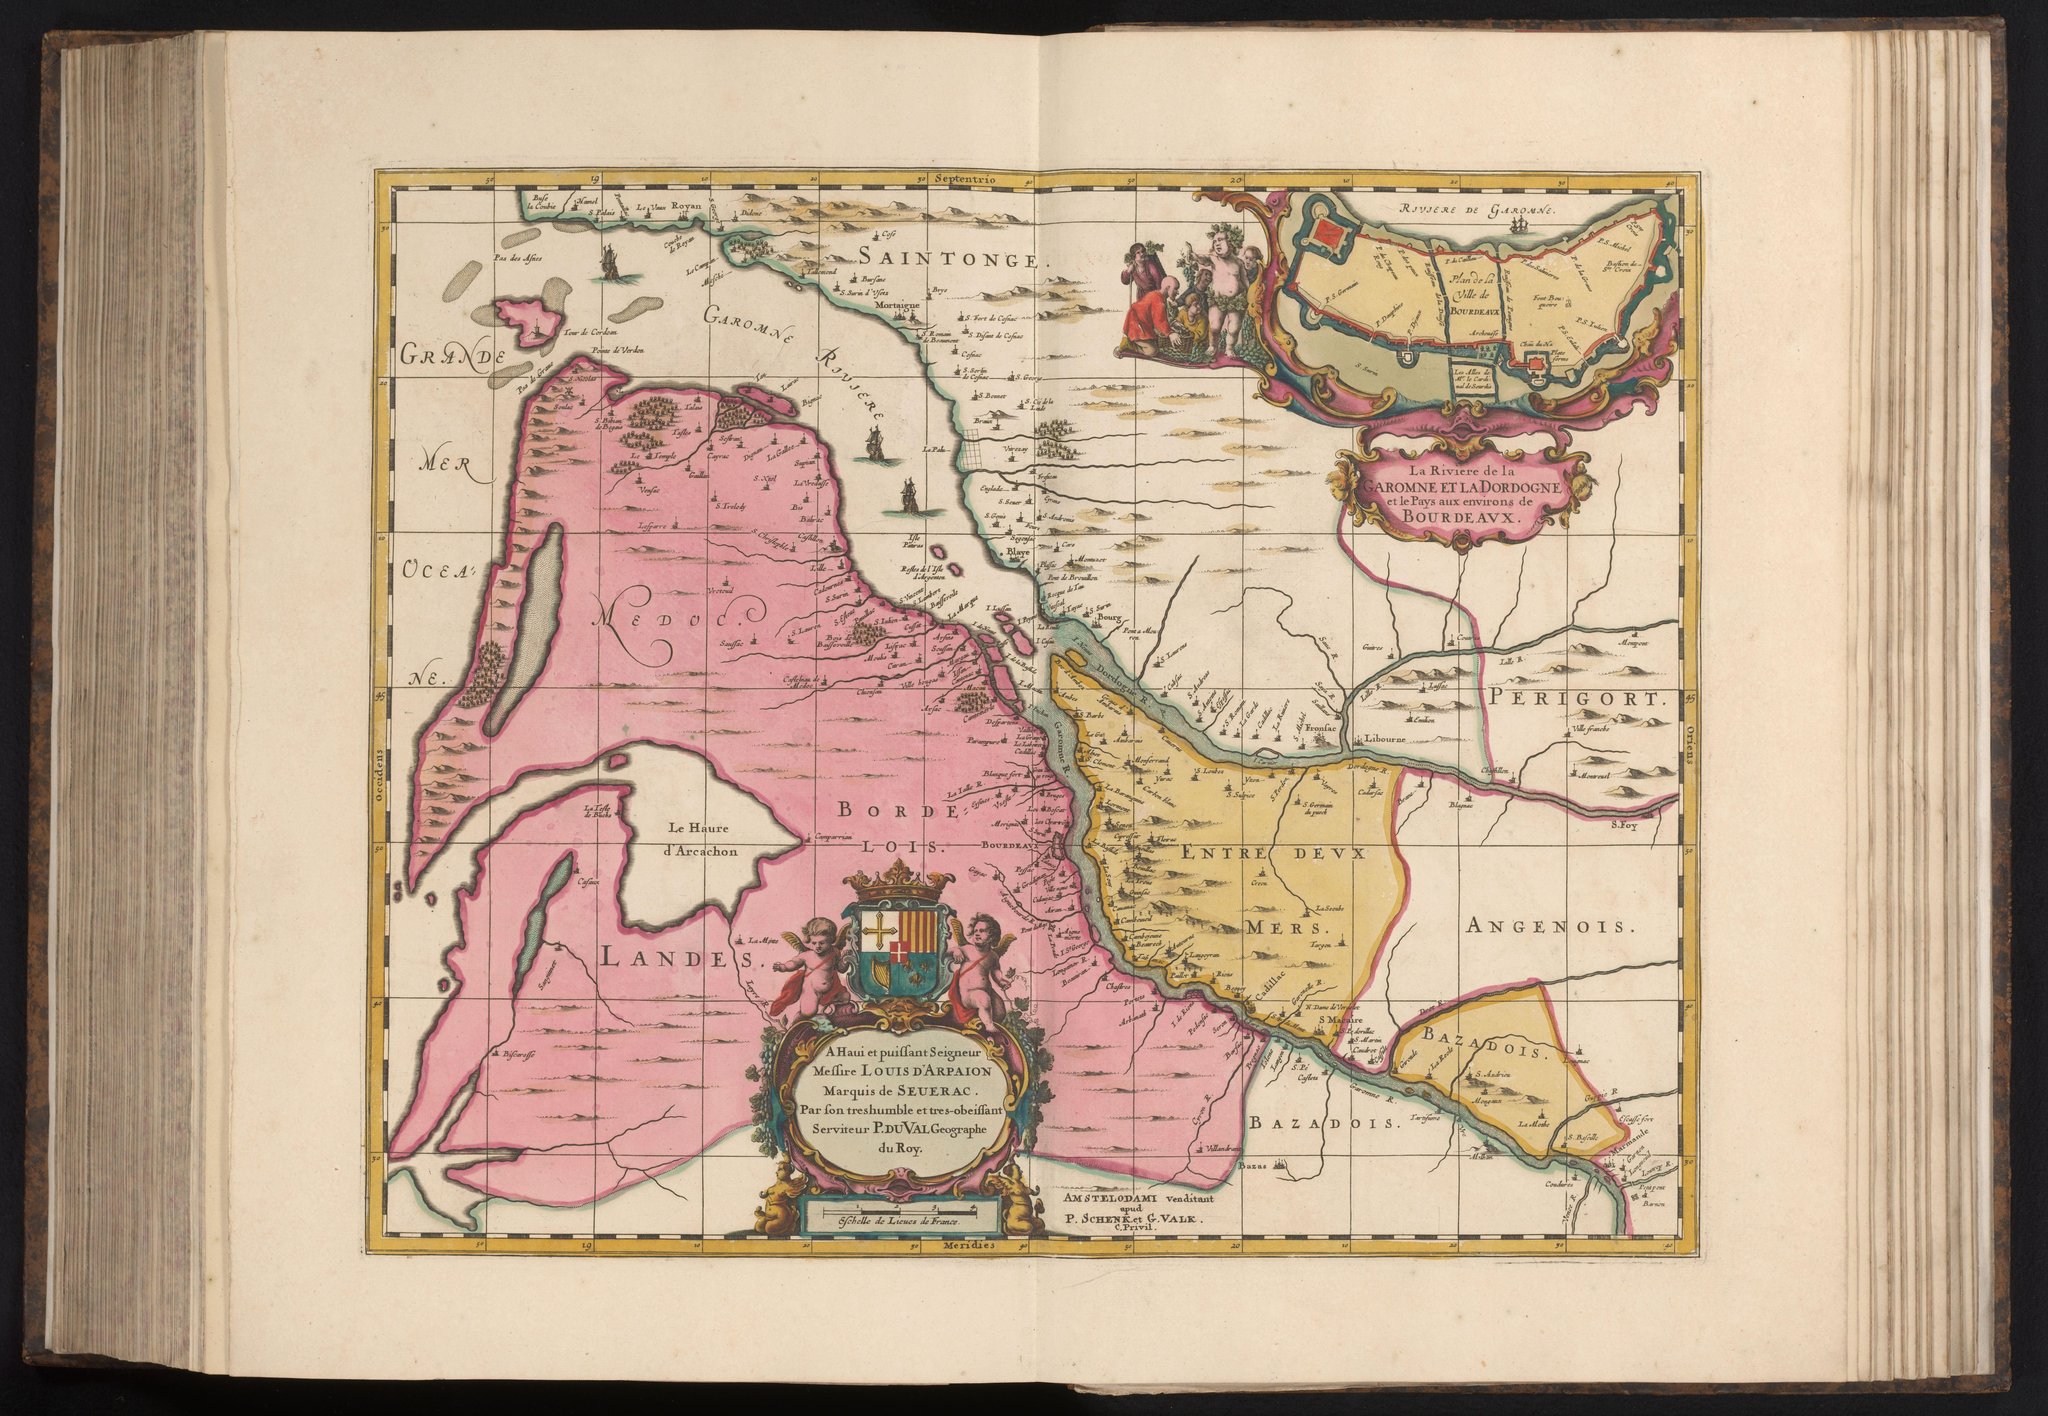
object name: print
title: La riviere de la Garomne et la Dordogne et la pays aux environs de Bordeaux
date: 1670-1683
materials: paper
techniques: engraving, etching, hand coloring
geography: amsterdam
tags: maps of separate countries or regions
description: Met als inzet een vestingplattegrond van Bordeaux. Deze prent maakt deel uit van een album.